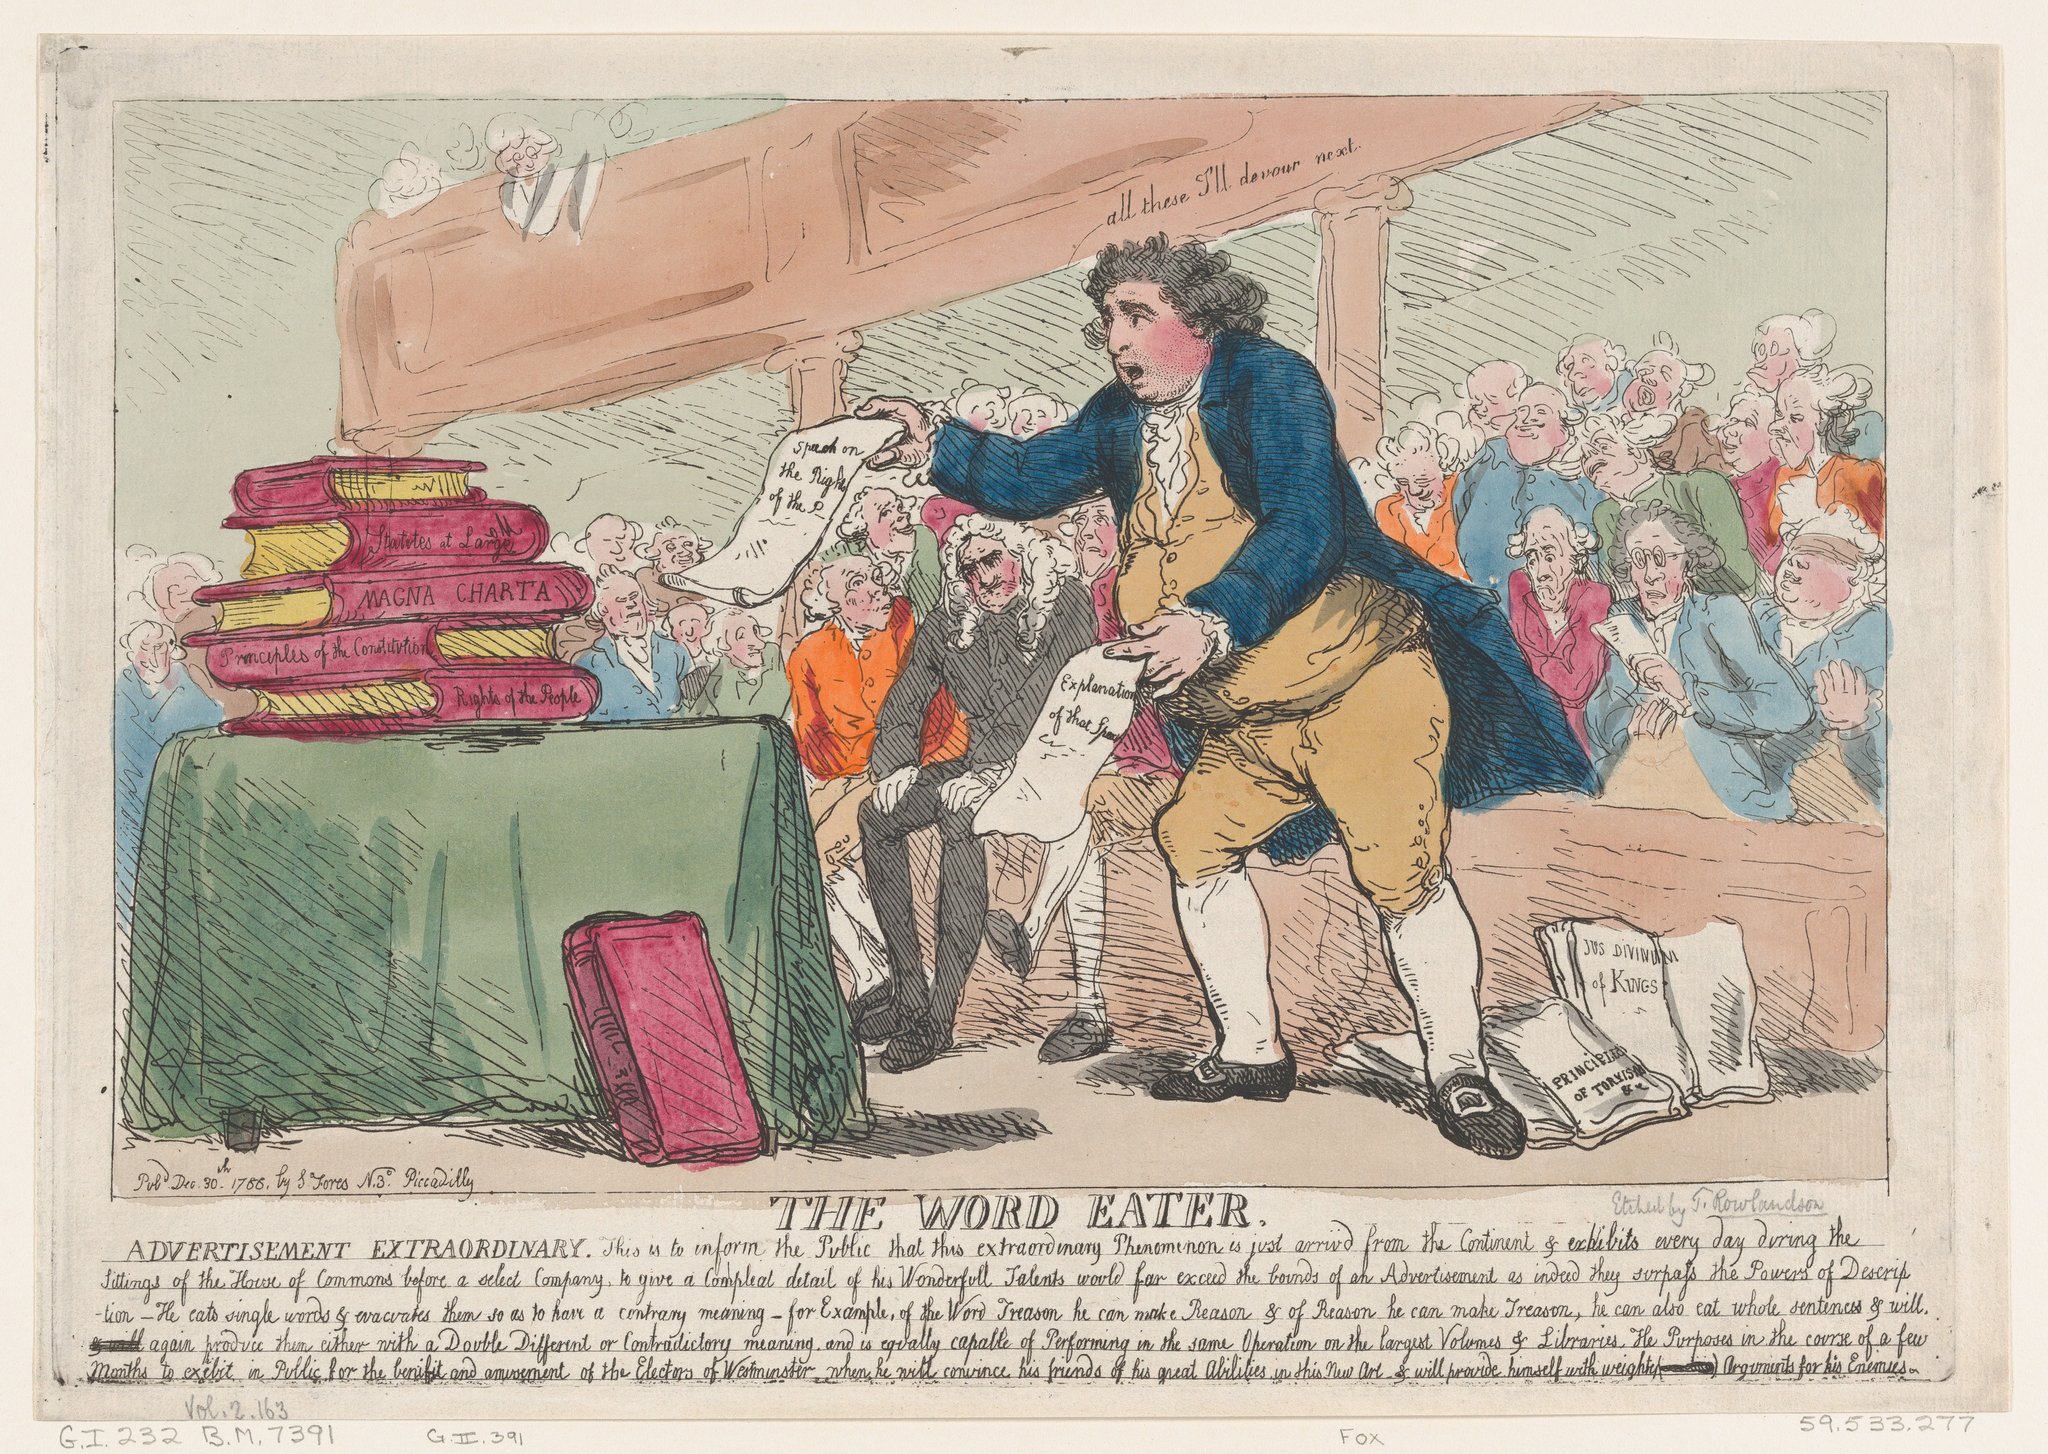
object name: print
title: The Word-Eater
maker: thomas rowlandson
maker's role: artist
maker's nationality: british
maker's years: 1757-1827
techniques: etching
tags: men,women